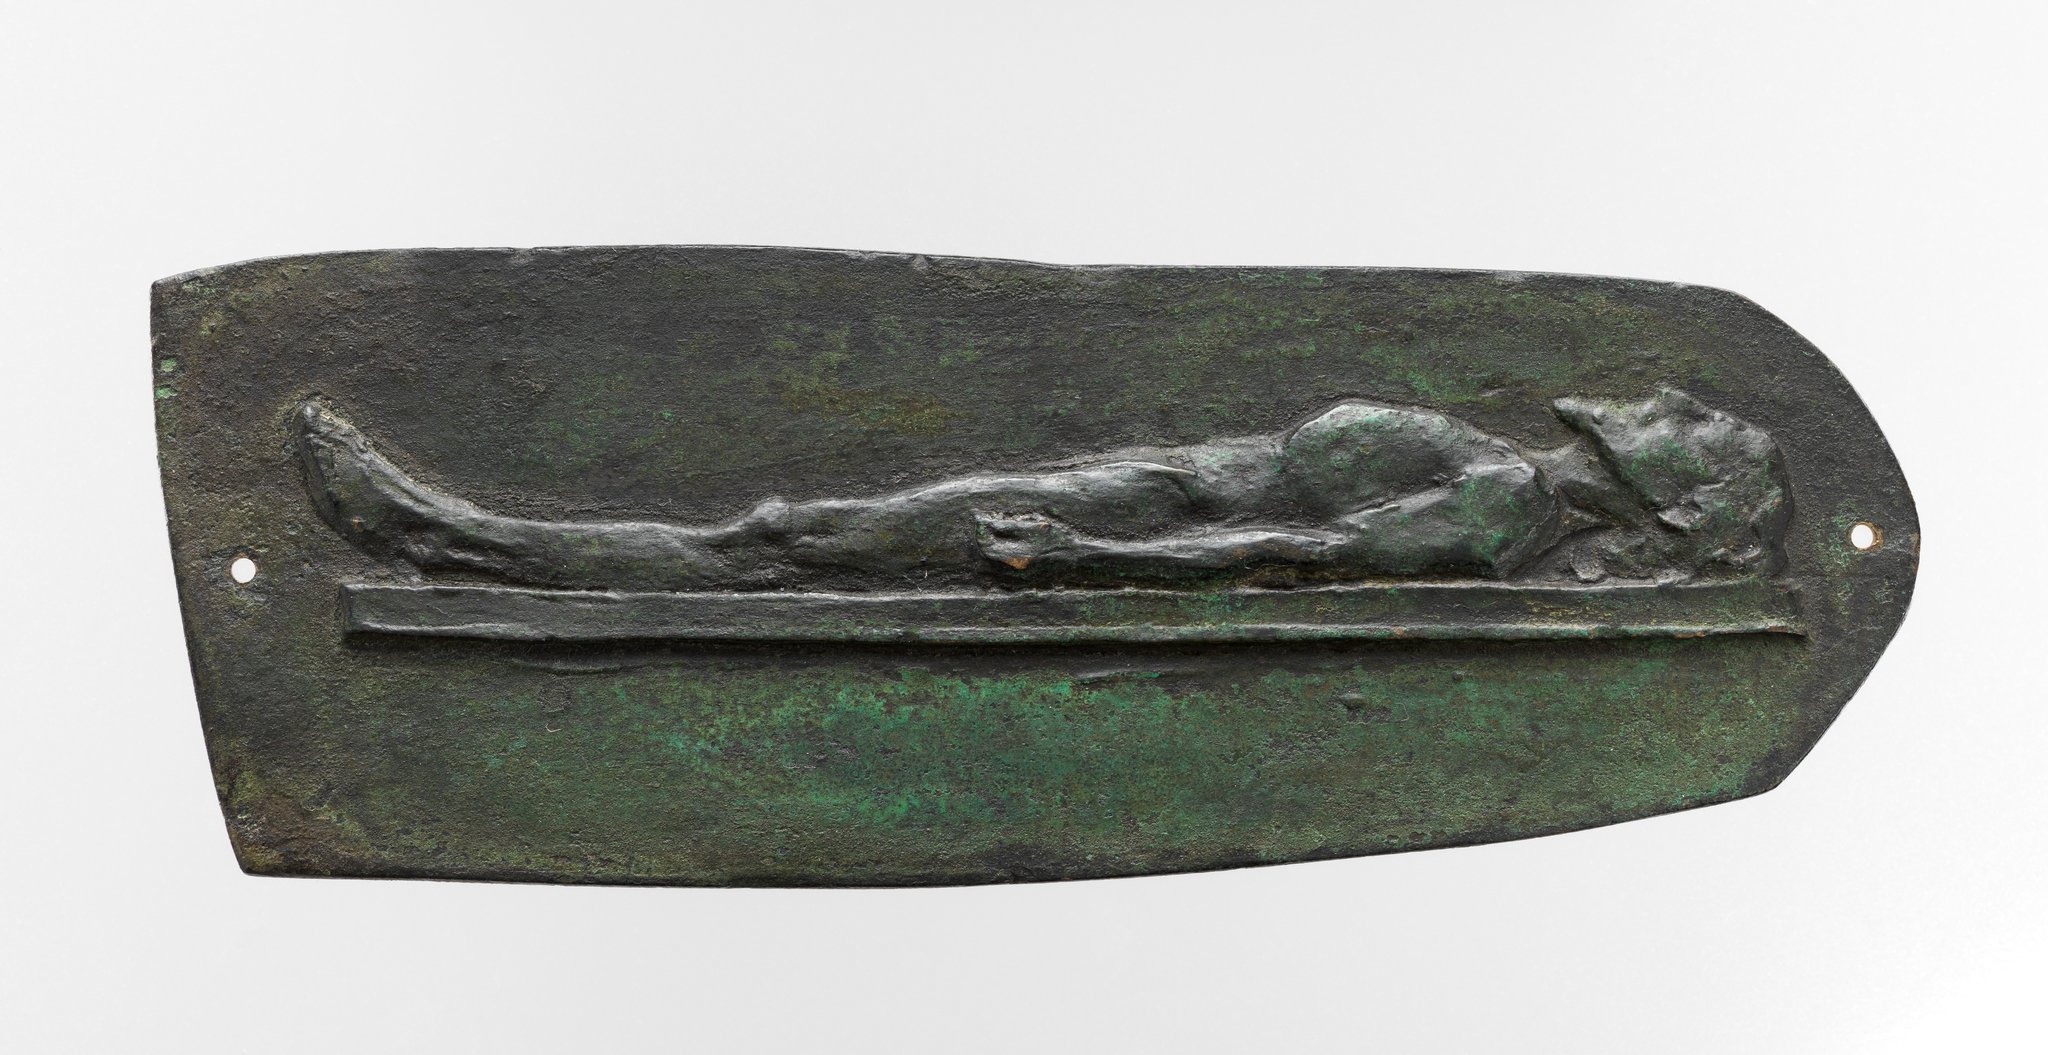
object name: plaquette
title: Le Christ mort / Christ couché nu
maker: alexandre-louis-marie charpentier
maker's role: maker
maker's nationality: french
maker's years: 1856-1909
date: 1895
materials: bronze, patina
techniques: casting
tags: christ